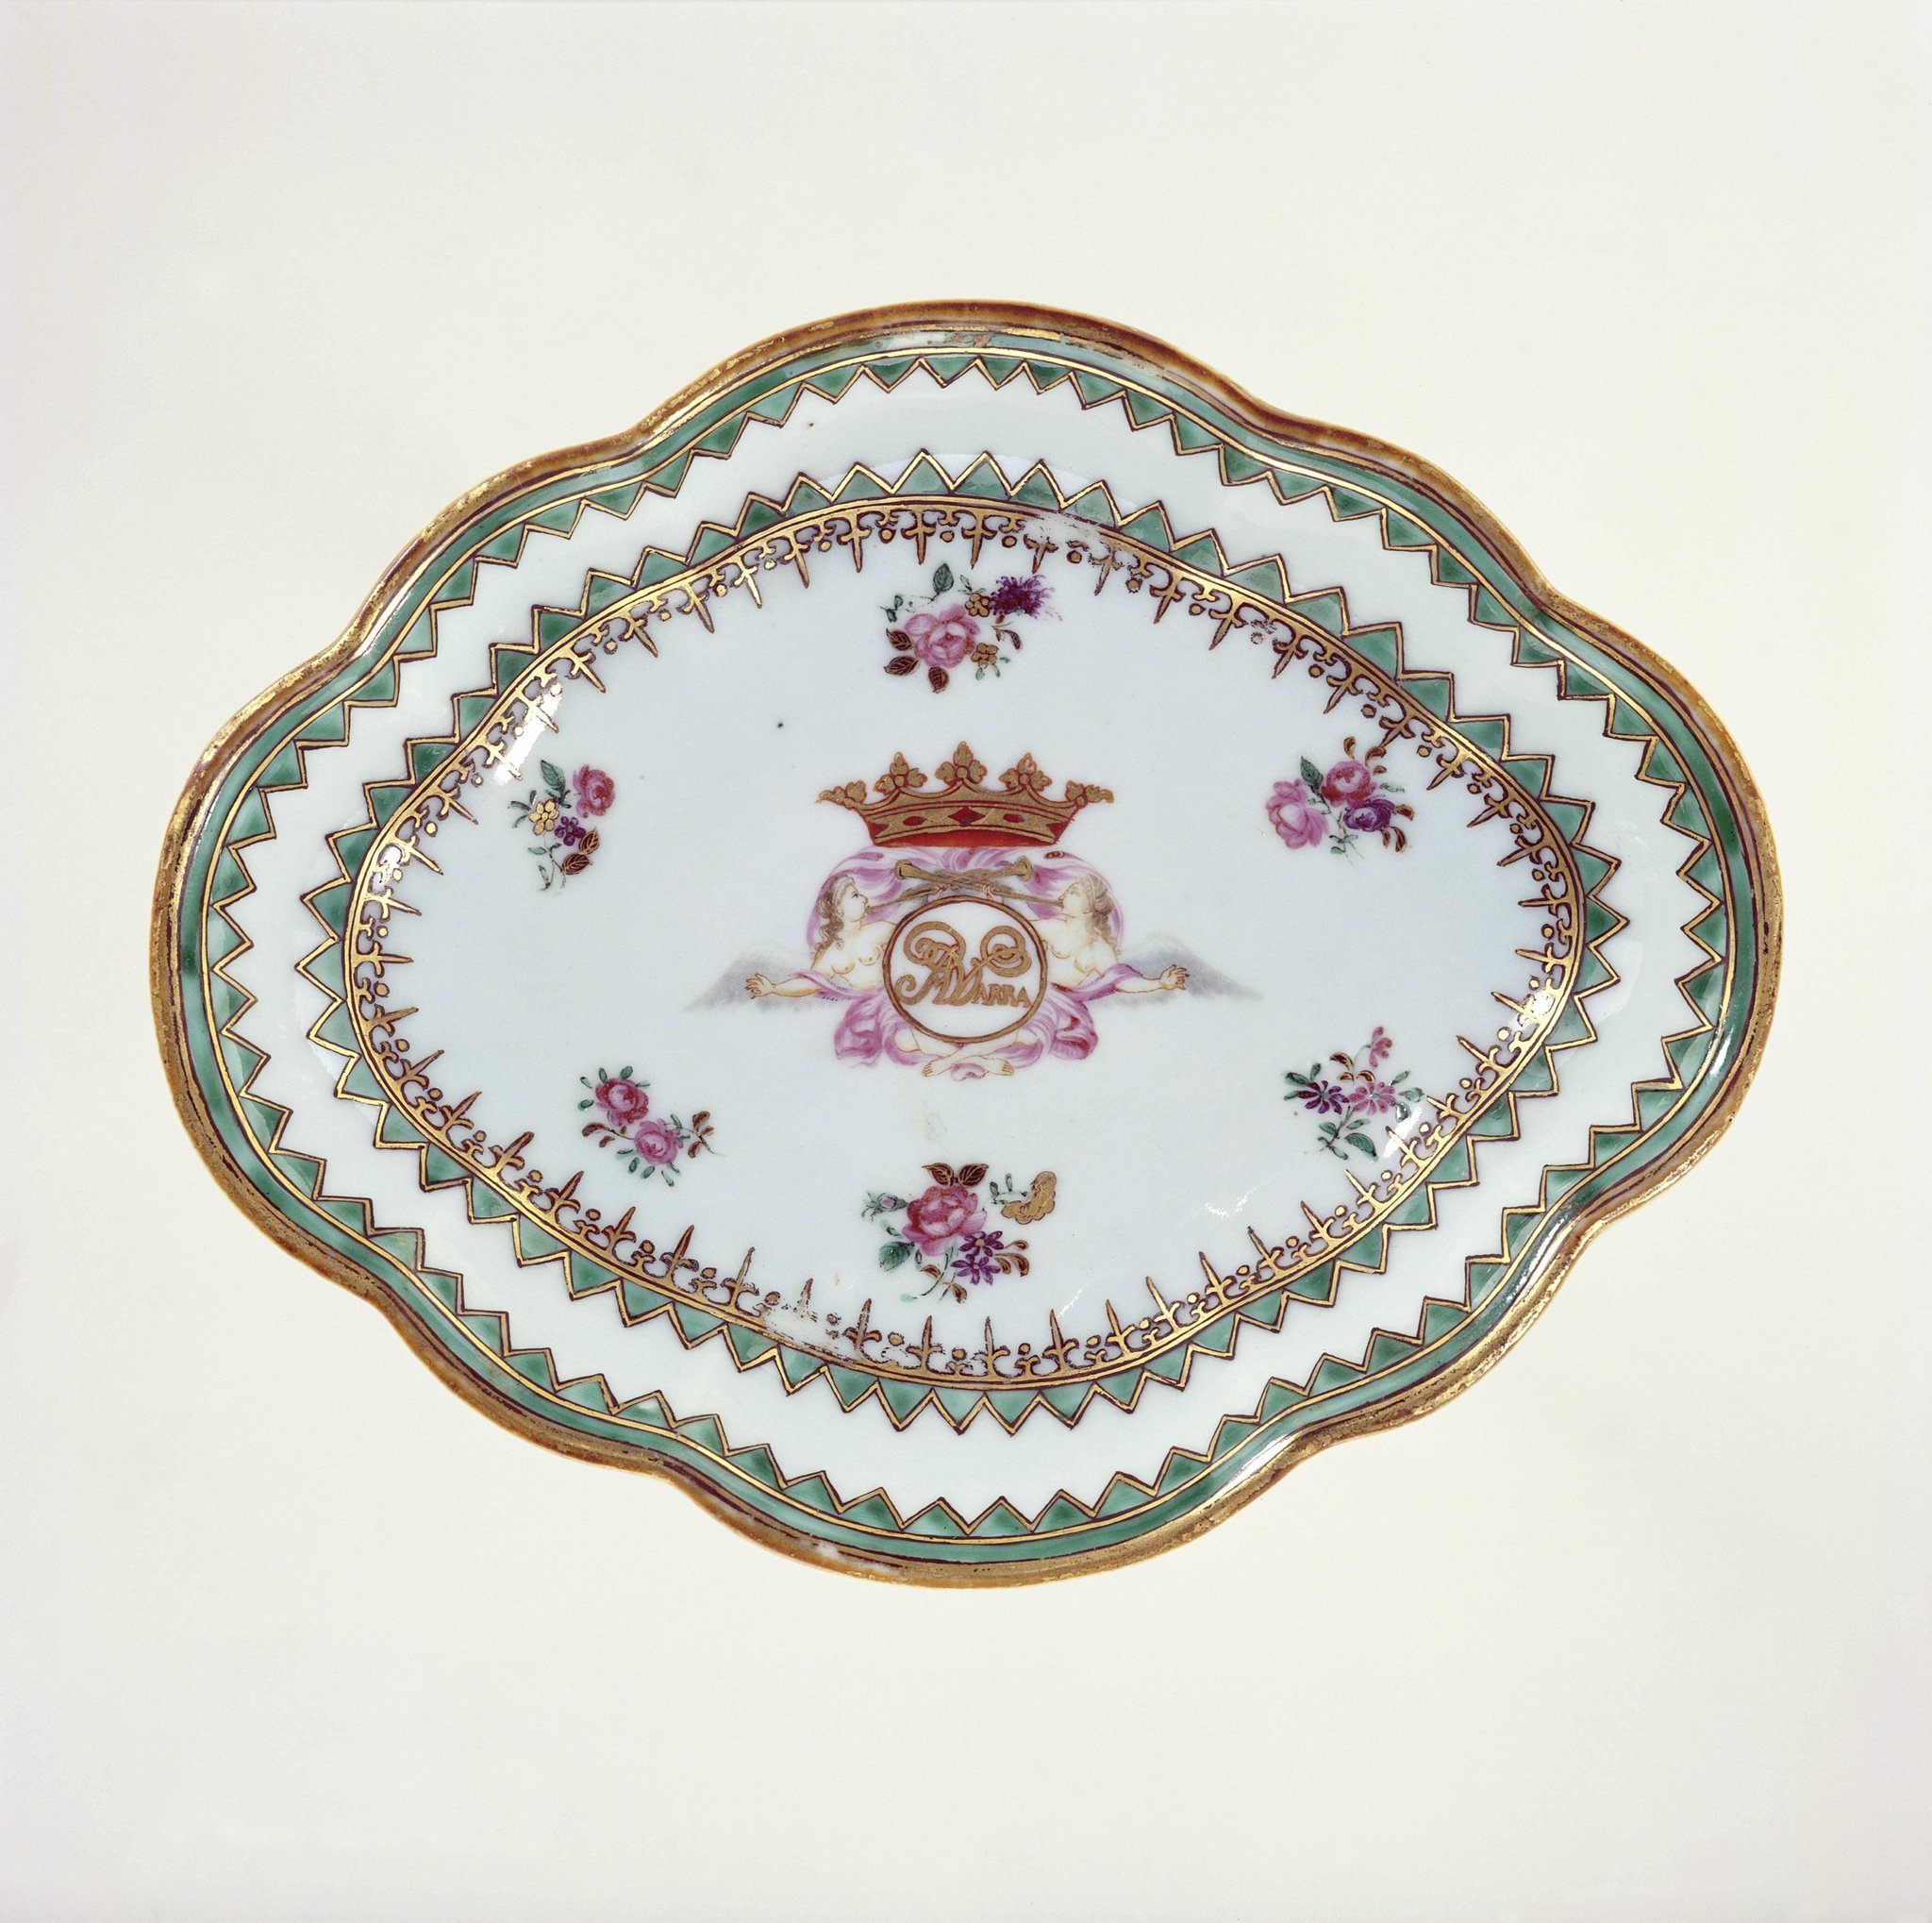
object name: dish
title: Oval saucer-dish with the arms of the Van der Parra family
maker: Anonymous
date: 1750-1774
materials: glaze, gold, paint, porcelain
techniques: firing, gilding, turning, vitrification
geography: china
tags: dutch east indies, the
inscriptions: label: ‘CNO/ 17 b’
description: Ovale schaal van porselein met gelobde wand en geschulpte rand, beschilderd op het glazuur in rood, roze, groen, paars, zwart en goud. In het centrum het wapen van Petrus Albertus van de Parra (1714-1775). In het schild staat de naam ‘PA VD PARRA’ in goud en ijzerrood. Boven het wapen is een kroon afgebeeld en het dekkleed bestaat uit een draperie in paars en aan weerszijden van het wapen een engel die de bazuin blaast. Hieromheen zijn bloemtakken afgebeeld. Op de wand een band van spearheads in goud. De rand wordt begrensd met een dubbel zaagtand-motief. Op de onderzijde een oud label met 'CNO 17 b'. Wapenporselein.